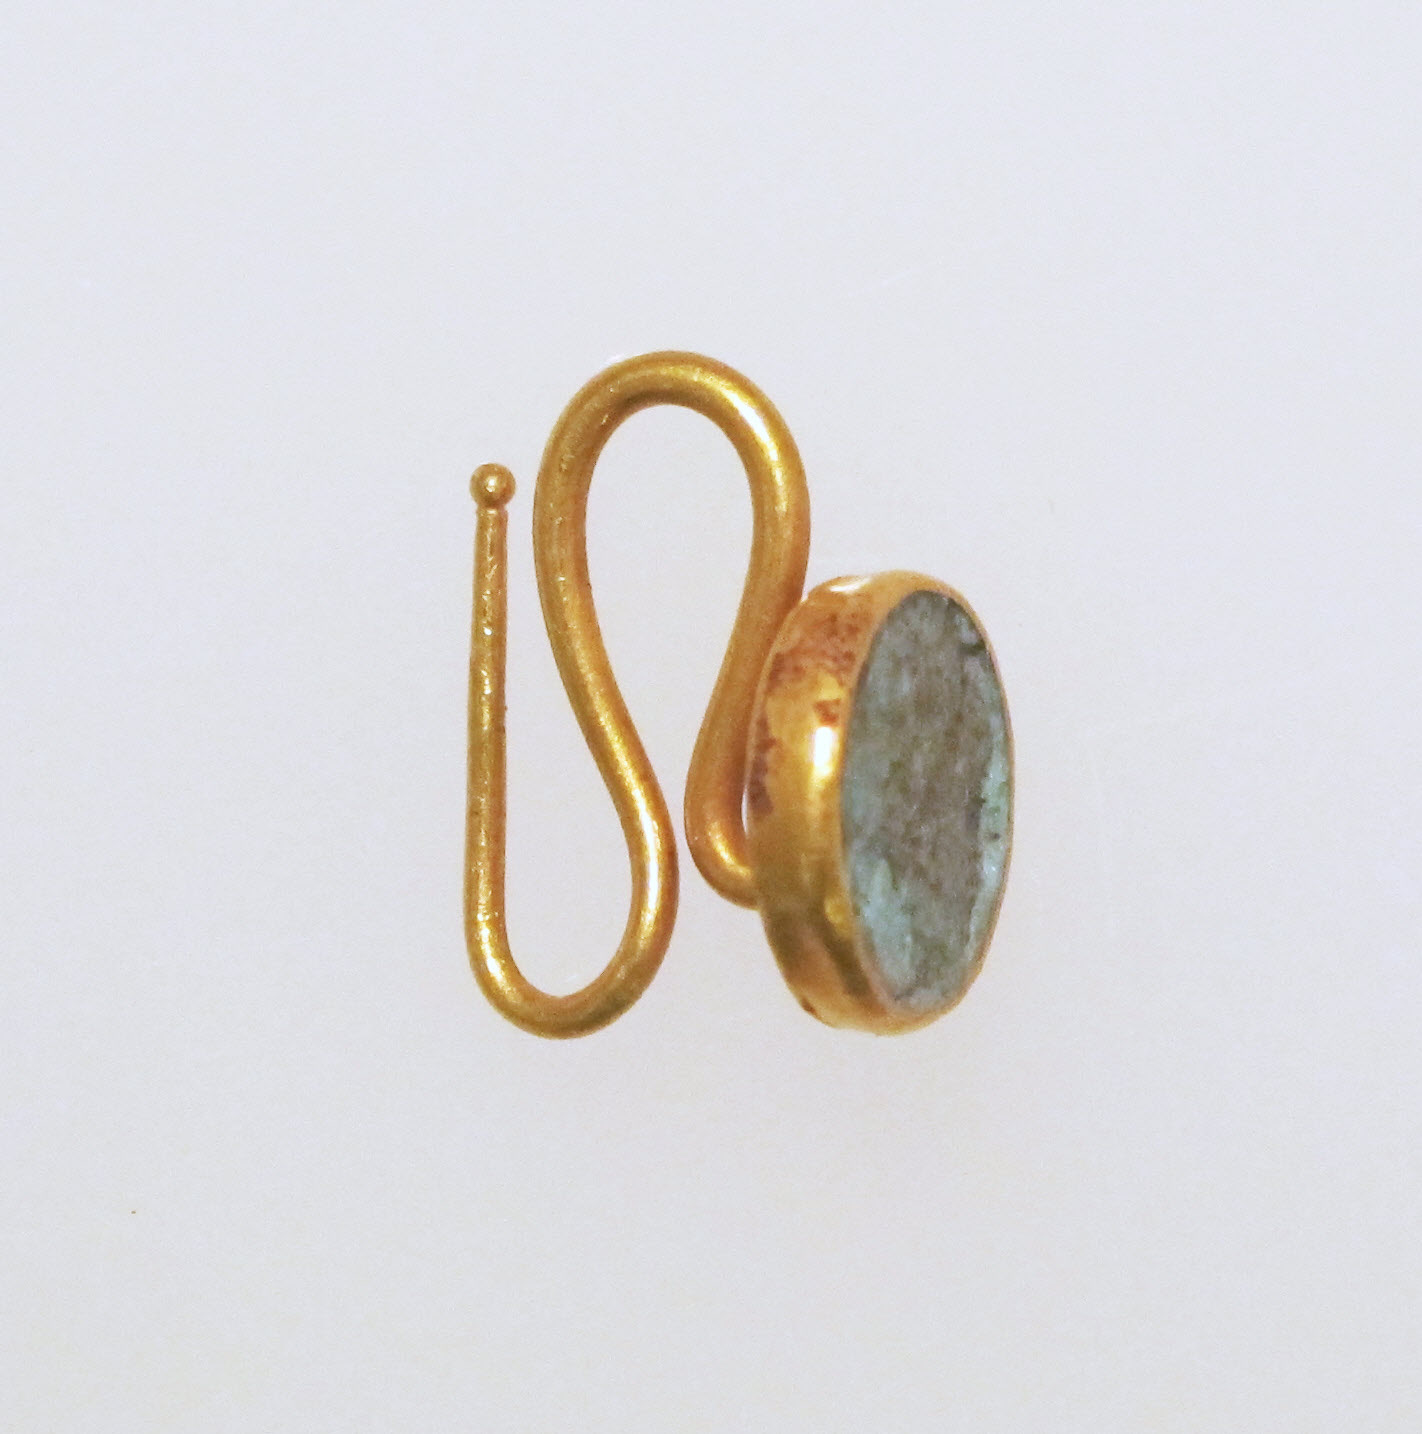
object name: earring hook type with disc and paste setting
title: Earring-hook type with disc and paste setting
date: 7000 BCE-330 CE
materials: glass, gold, paste